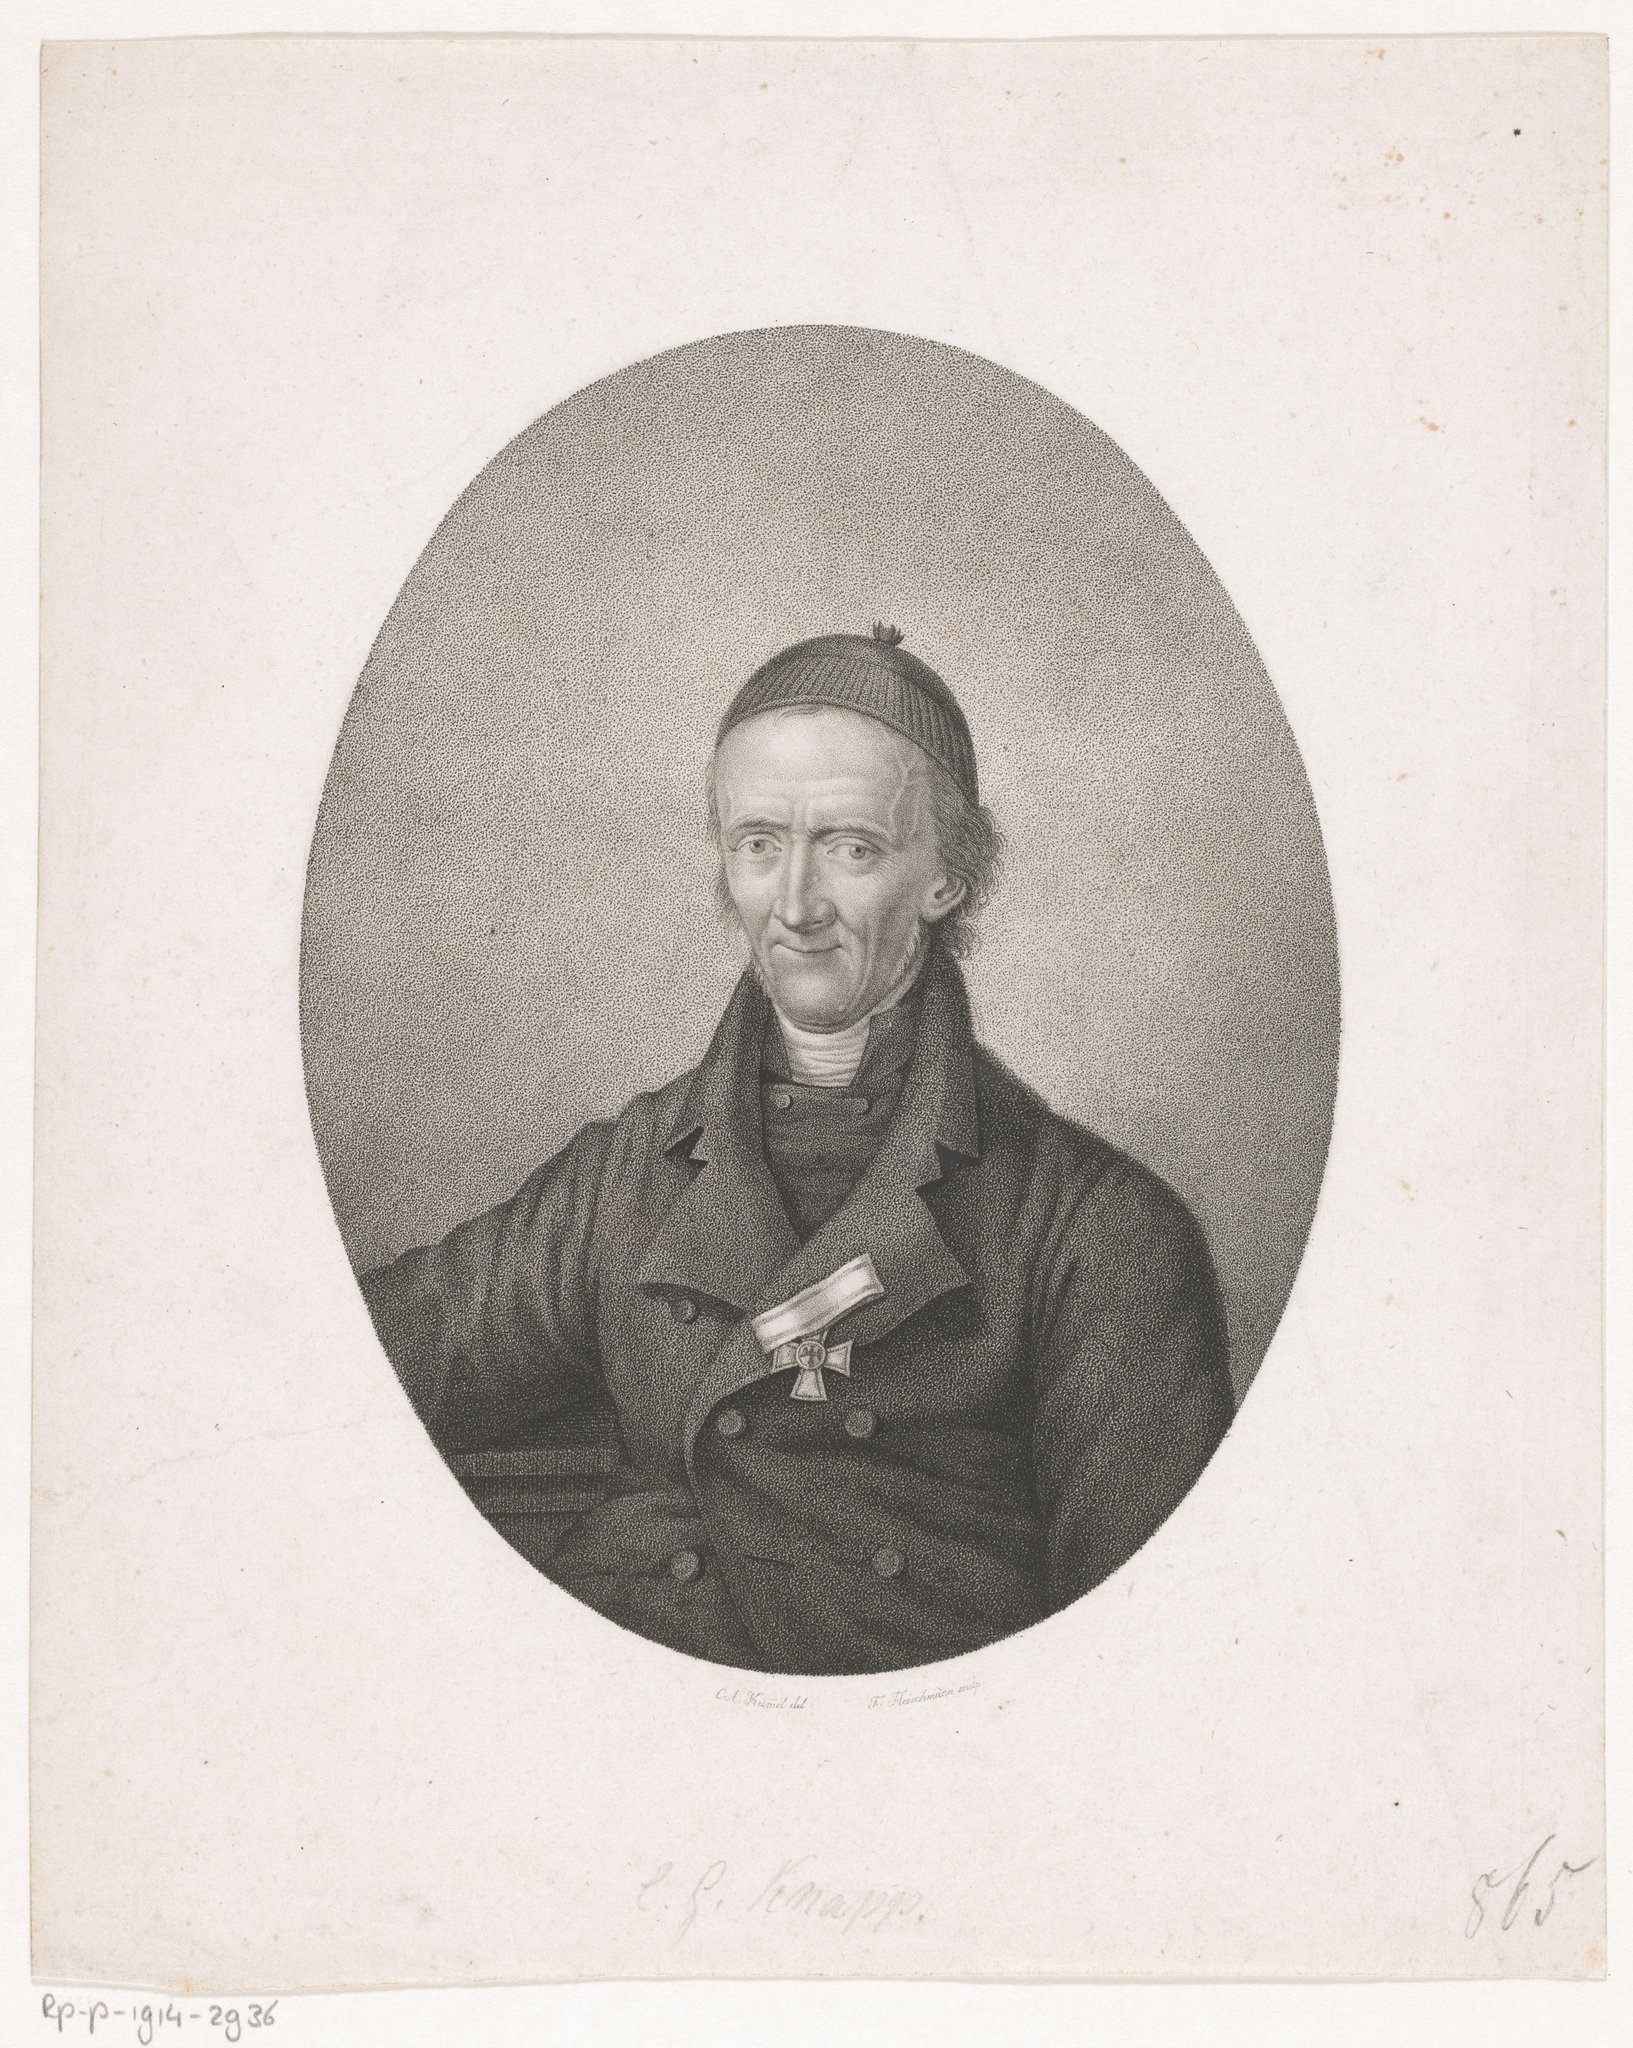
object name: print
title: Portret van Georg Christian Knapp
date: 1801-1834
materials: paper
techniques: stippling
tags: knighthood order, historical persons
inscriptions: collector's mark: Lugt 2228